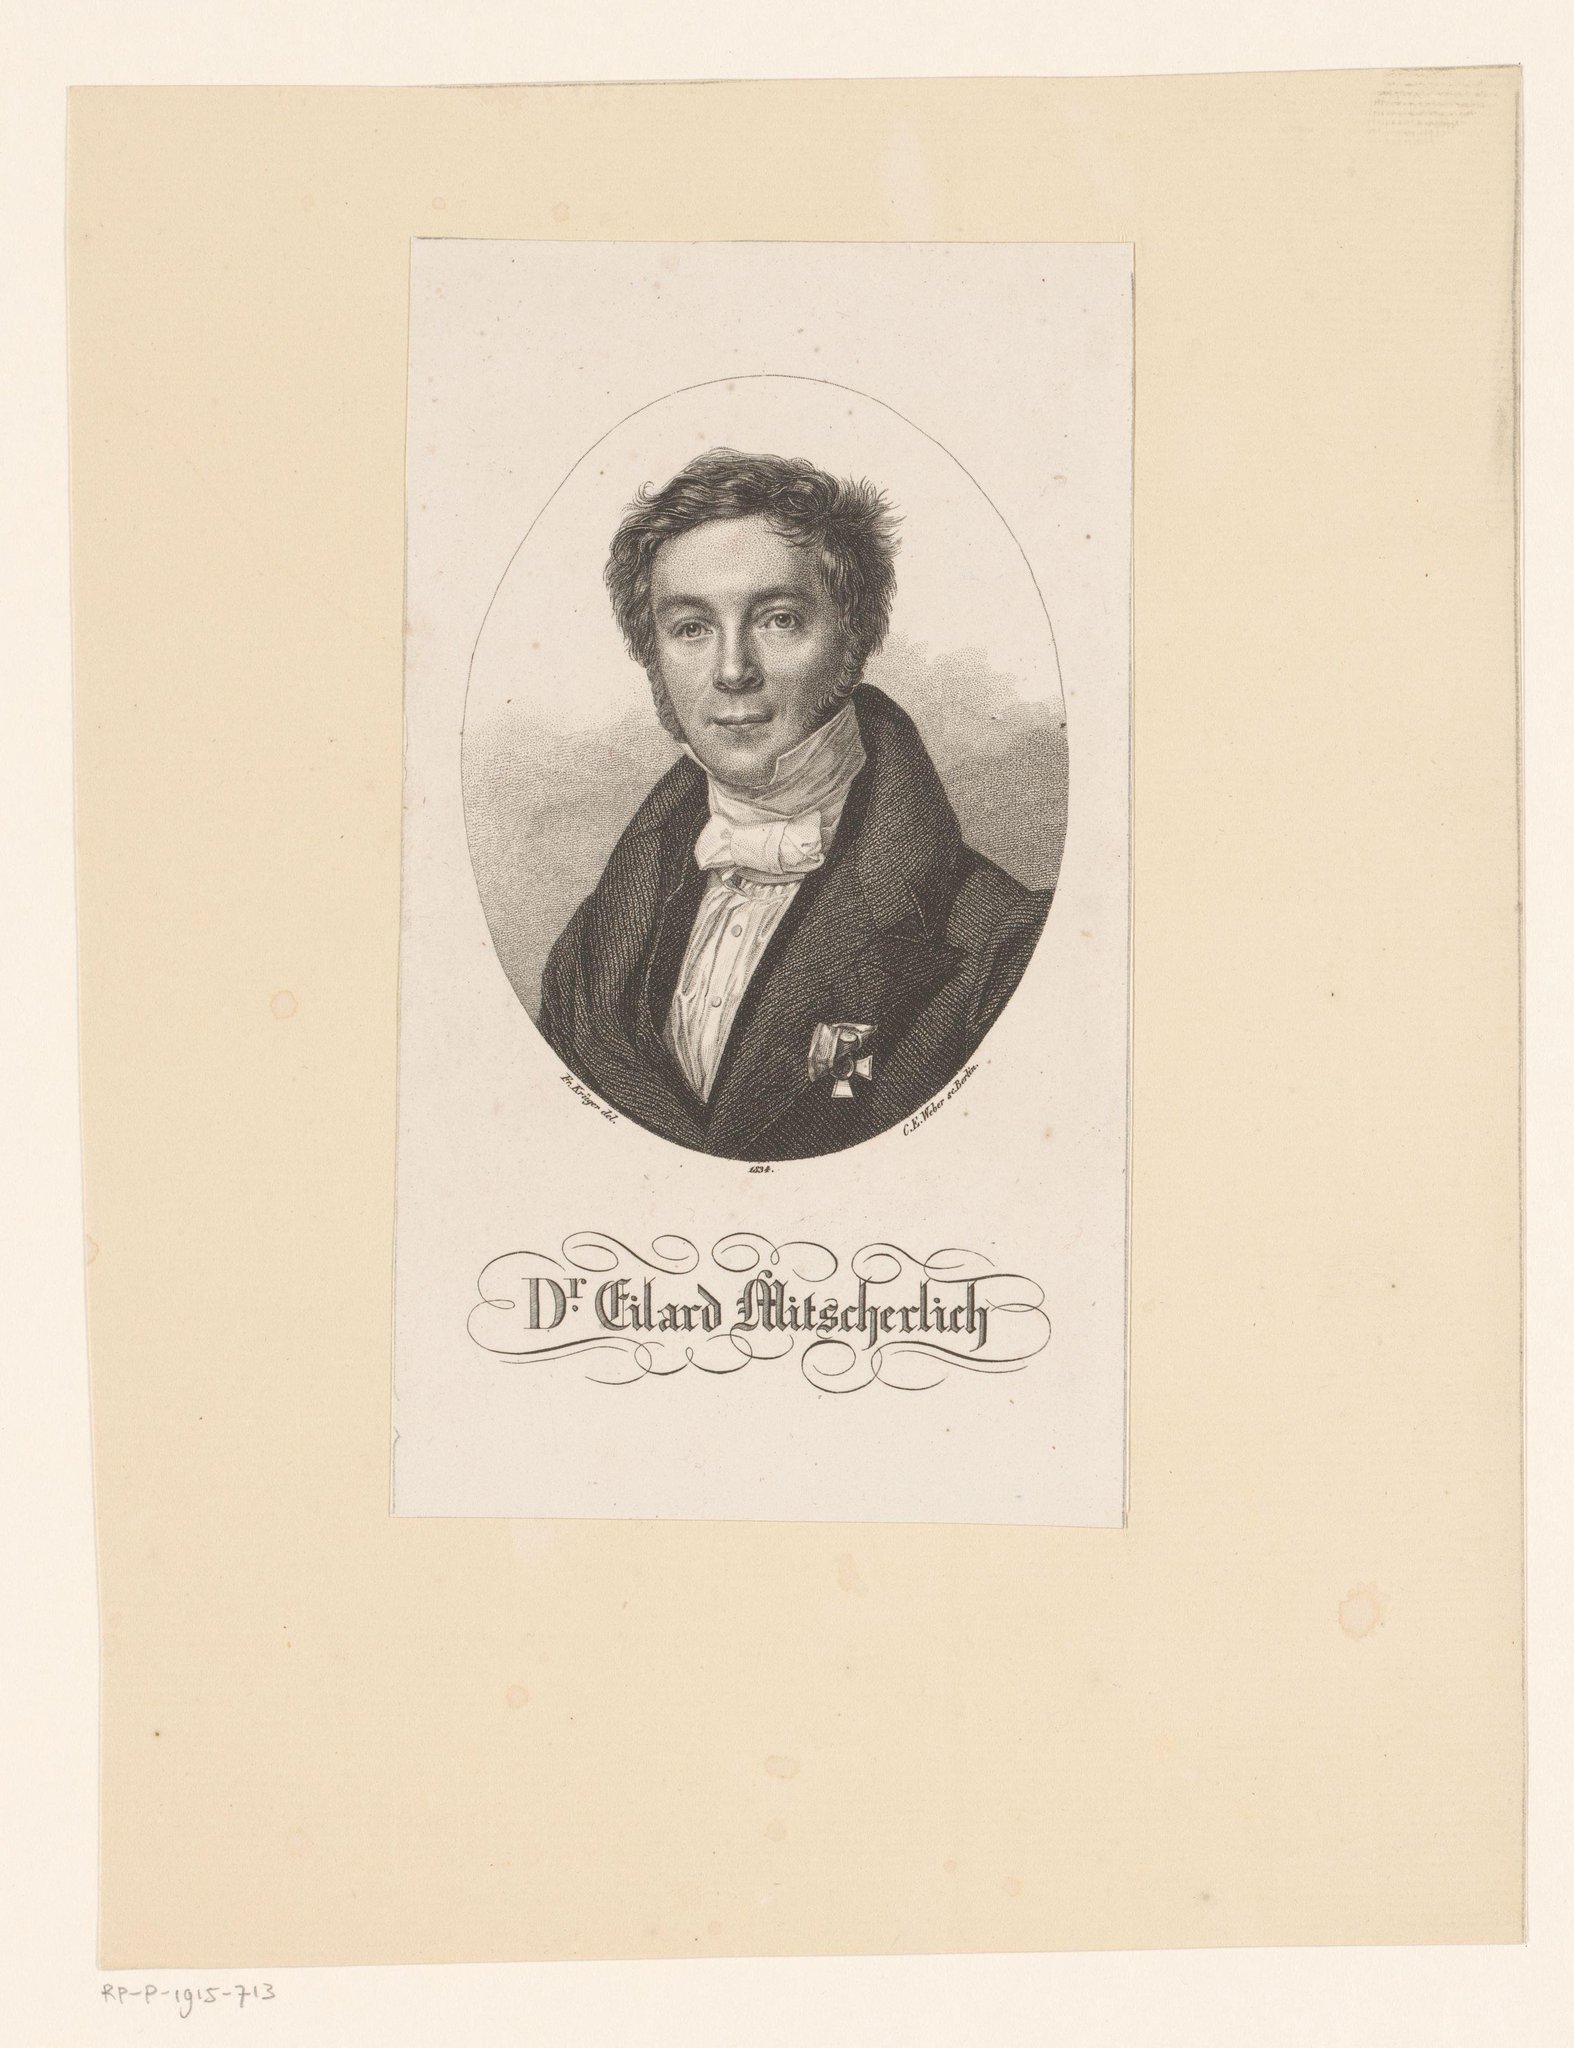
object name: print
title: Portret van Eilhard Mitscherlich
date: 1834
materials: paper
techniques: etching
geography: berlin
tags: historical persons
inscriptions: collector's mark: Lugt 2228